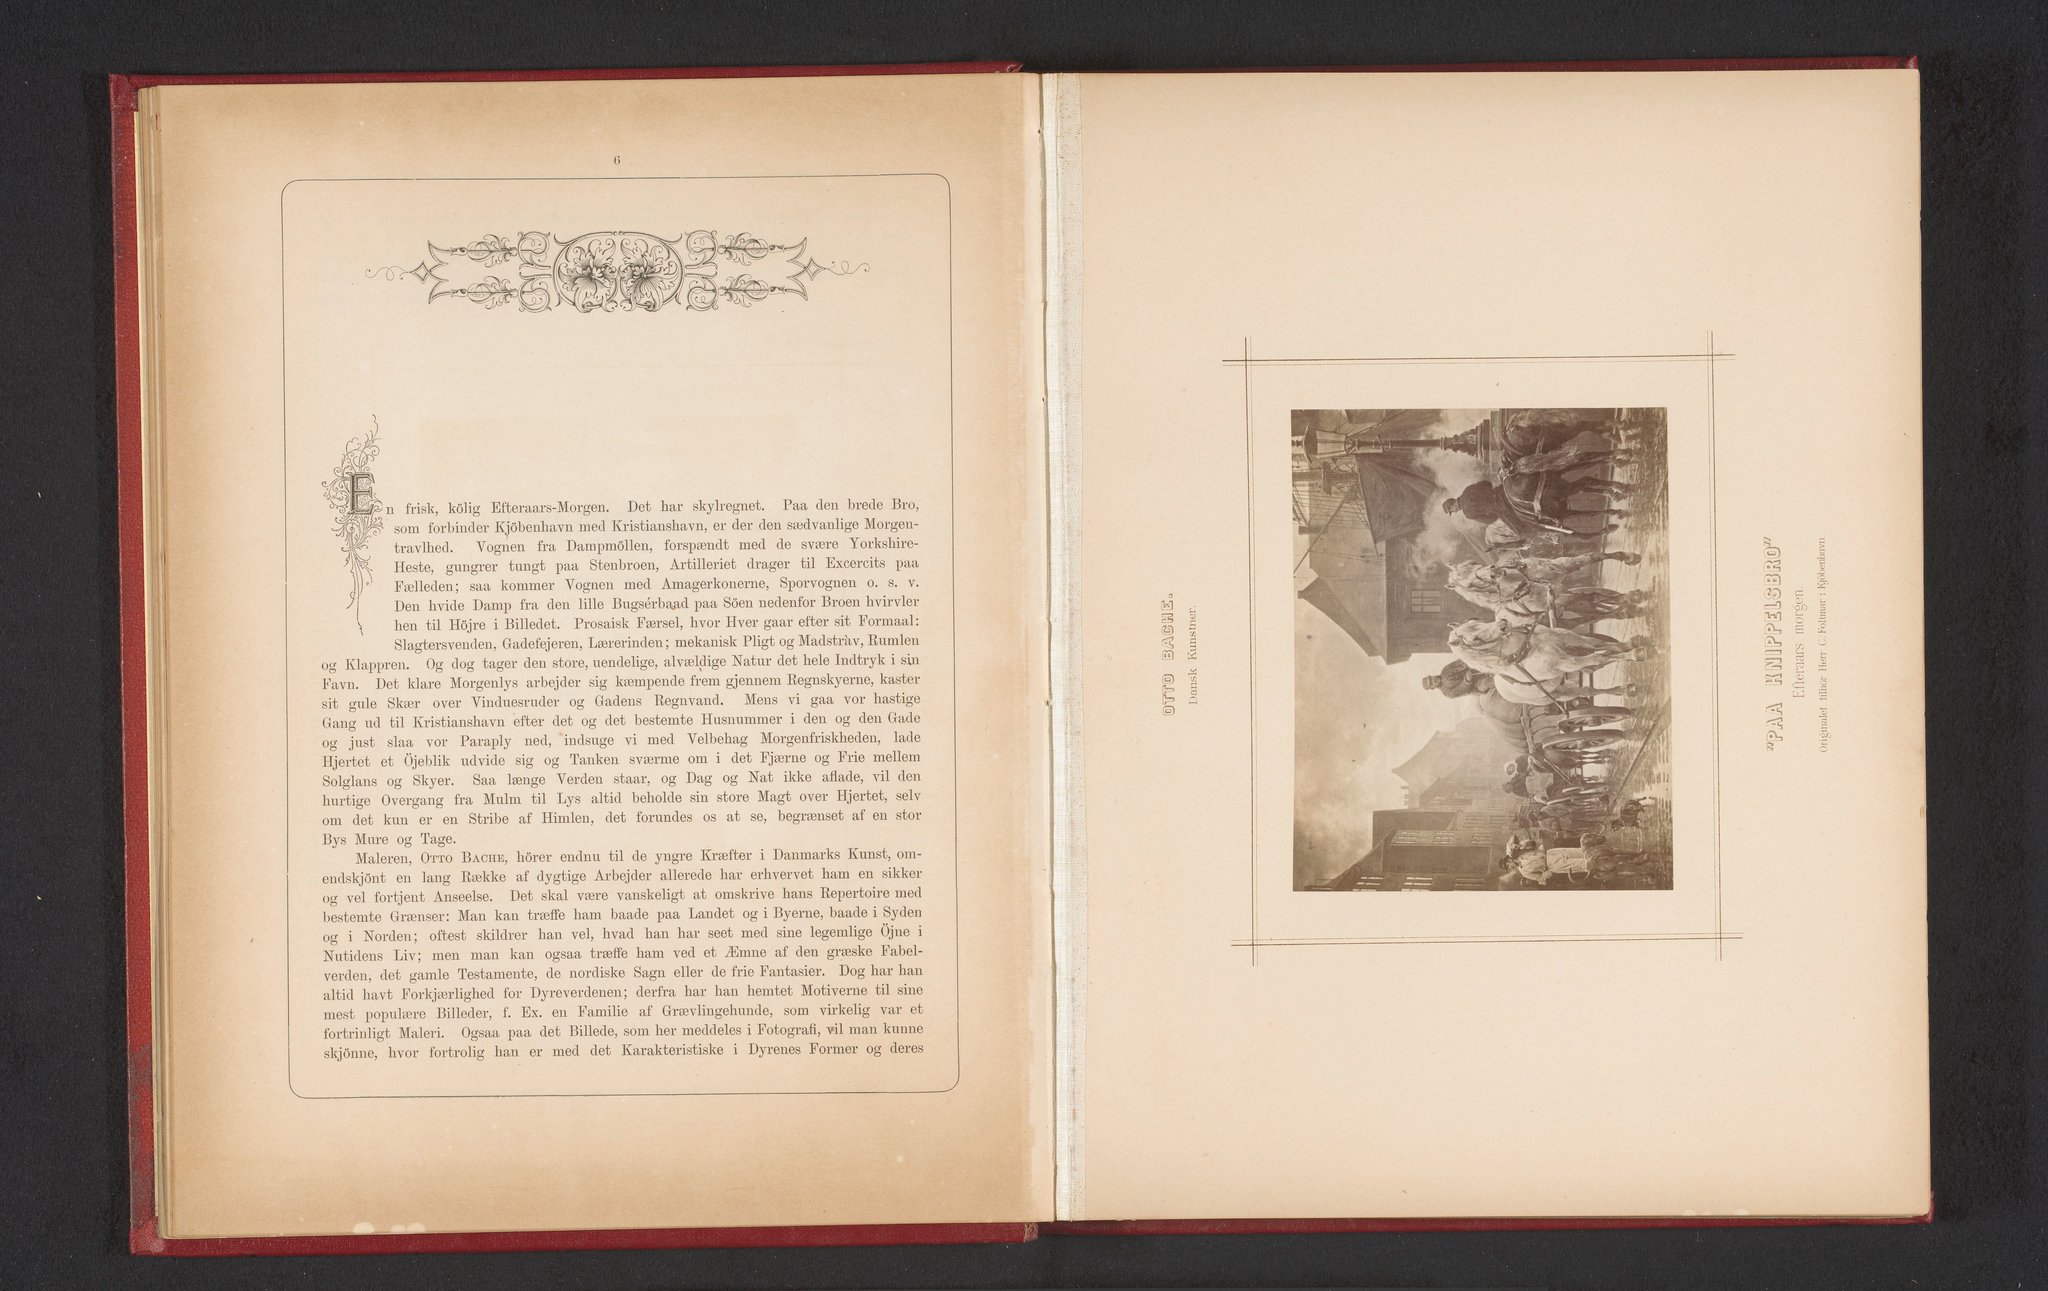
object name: page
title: Fotoreproductie van een schilderij van paard en wagen op een weg in een stad door Otto Bache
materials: photographic support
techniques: albumen print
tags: horse, four-wheeled vehicle drawn by two animals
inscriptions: inscription: ‘Dansk Kunstner’, inscription: ‘Efteraars morgen./ Originalet tilhör Herr C. Foltmar i Kjöbenhavn.’